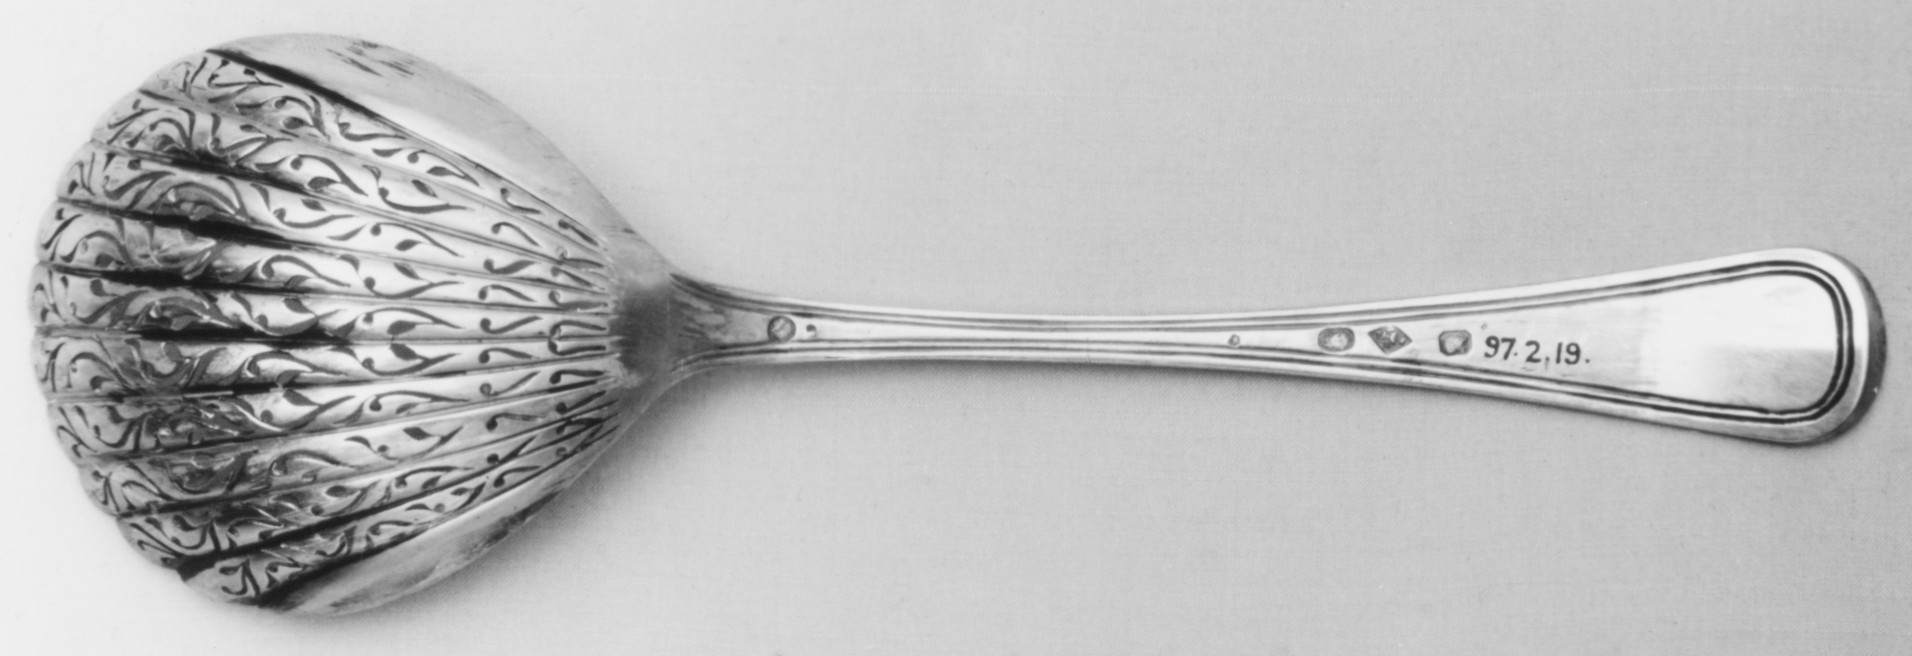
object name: sugar spoon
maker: a.c.c., paris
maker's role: maker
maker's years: 1750-1850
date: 1793-1794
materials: silver